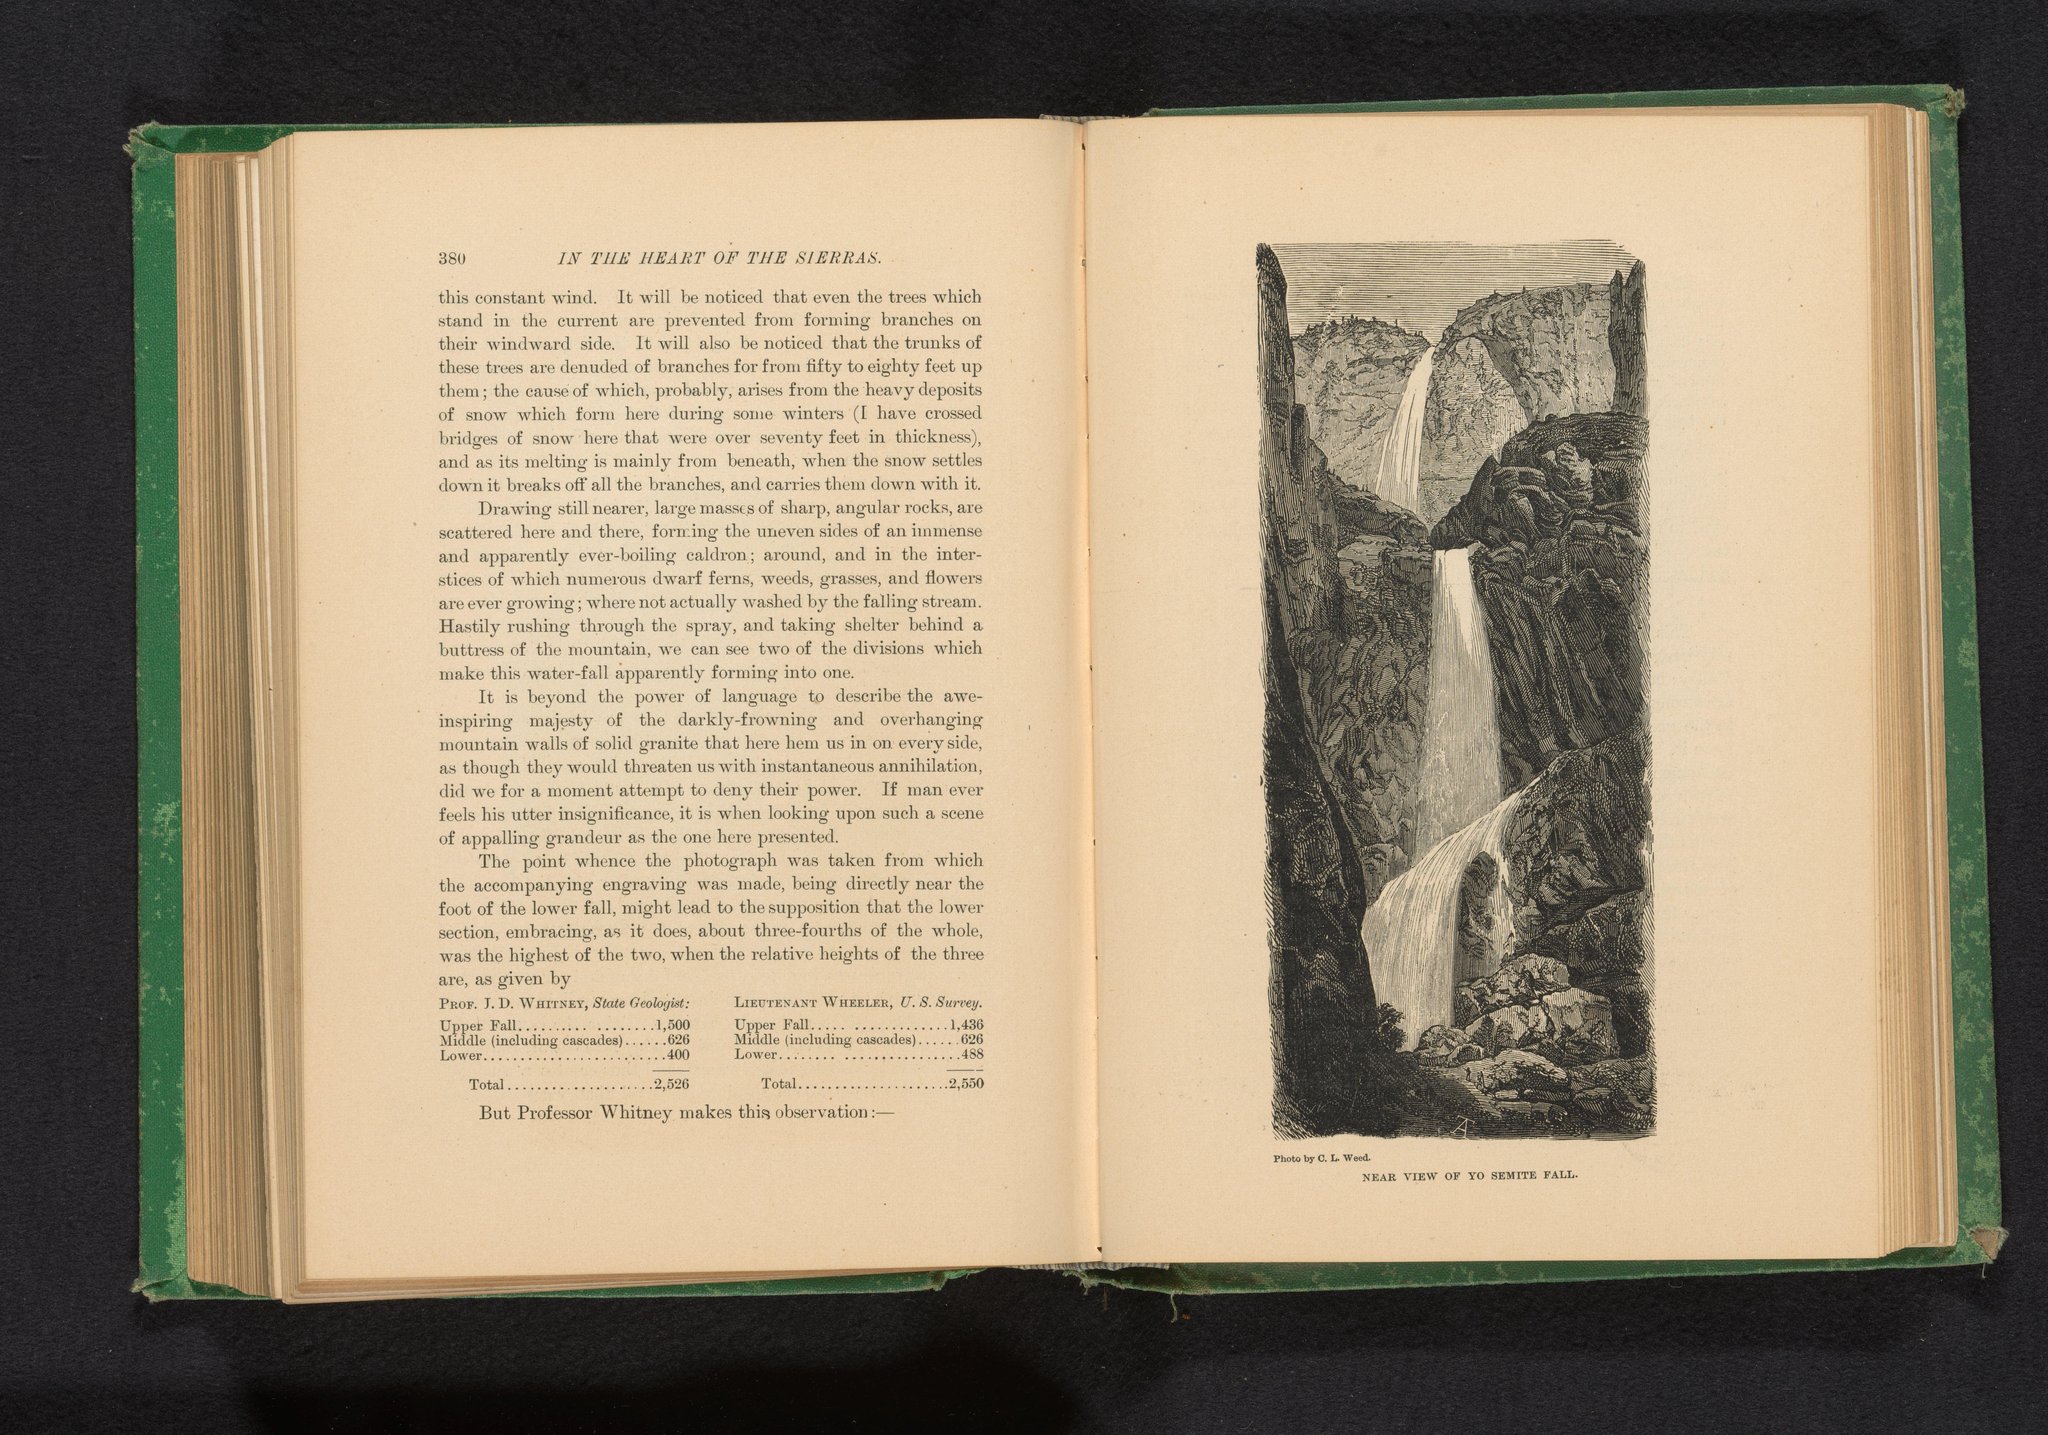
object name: photomechanical print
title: Gezicht op de Yosemite Falls, Californië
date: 1881-1886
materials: paper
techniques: printing block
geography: yosemite valley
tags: waterfall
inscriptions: monogram: ‘AT’